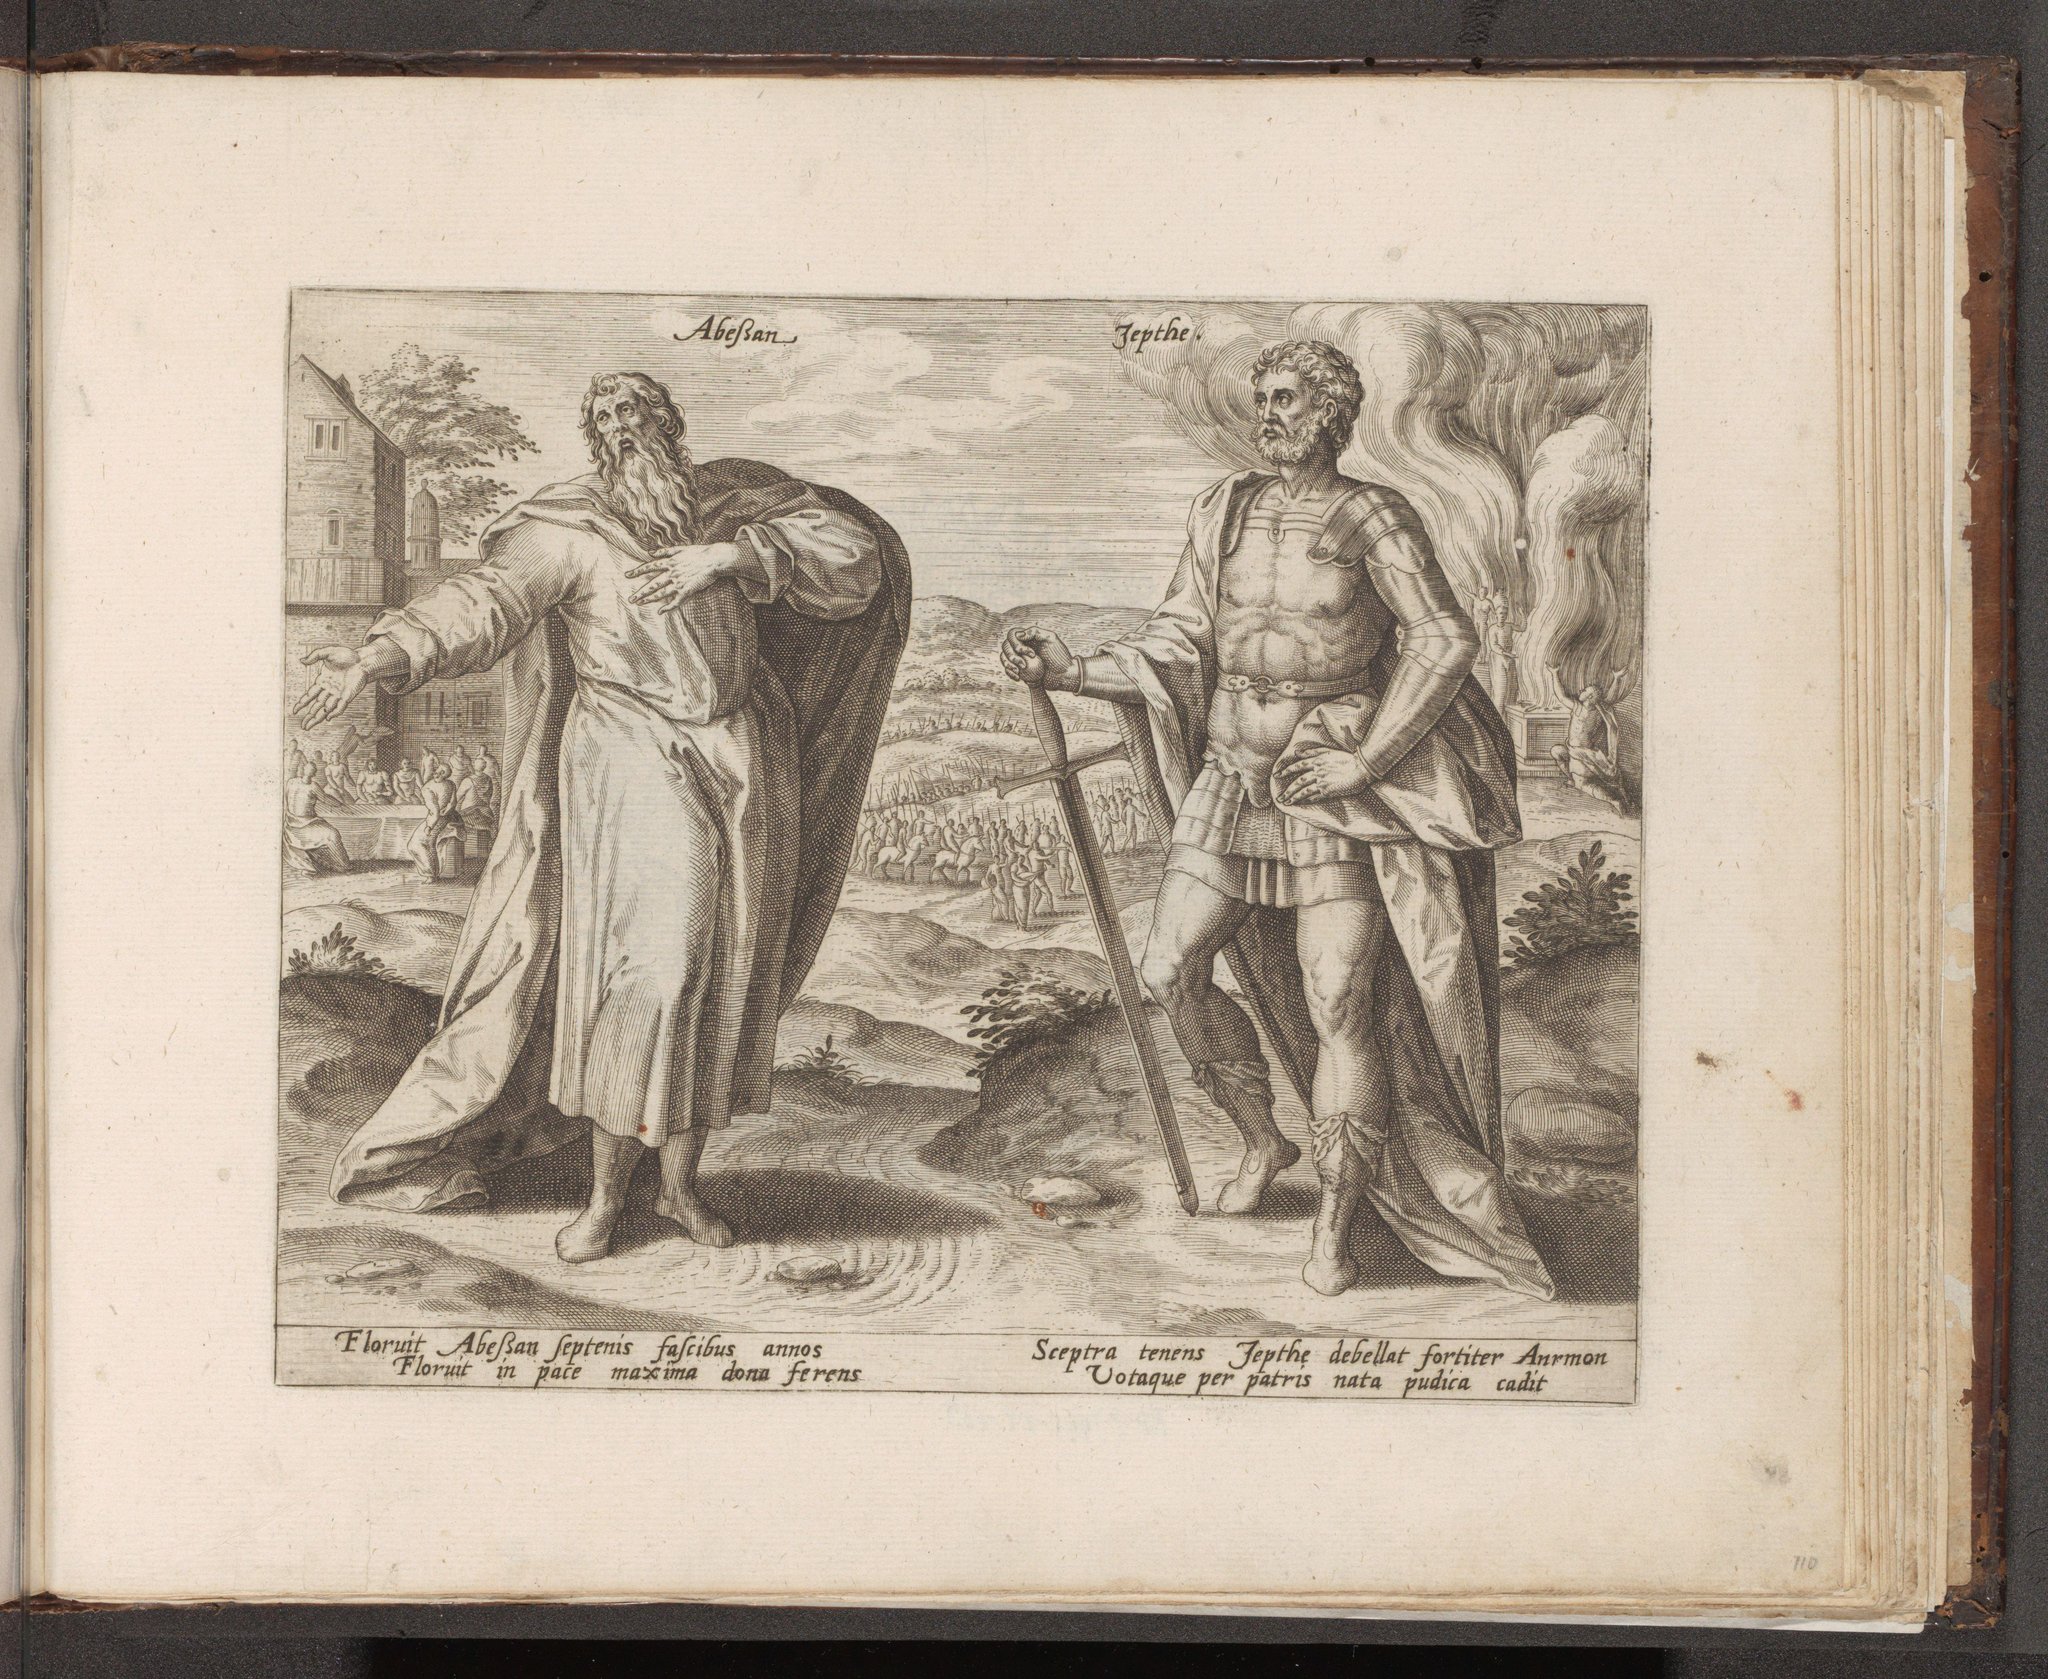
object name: print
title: De twaalf rechters van Israël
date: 1579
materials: paper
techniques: engraving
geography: antwerp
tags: fulfilment of jephthah's vow to the lord: jephthah's daughter is sacrificed, the time of ibzan (judges 12:8-10), jephthah's daughter dances with tambourines to meet her father on his return from the battle; jephthah rends his clothes in despair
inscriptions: caption: ‘Floruit Abessan...pudica cadit’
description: De rechters Ibsan en Jefta. Ibsan wijst op de scène op de achtergrond. Voor zijn huis zit een van zijn zonen of dochters aan het bruiloftsmaal. Ibsan huwelijkte zijn dertig zonen en dertig dochters uit. Jefta is gekleed in harnas en leunt op zijn zwaard. Op de achtergrond is te zien hoe zijn dochter voorop loopt in een stoet. Jefta had God beloofd om het eerste wat hij bij zijn thuiskomst zou zien te offeren. Rechts offert Jefta zijn dochter. Onder de voorstelling toelichtende teksten in het Latijn. Prent maakt deel uit van een album.